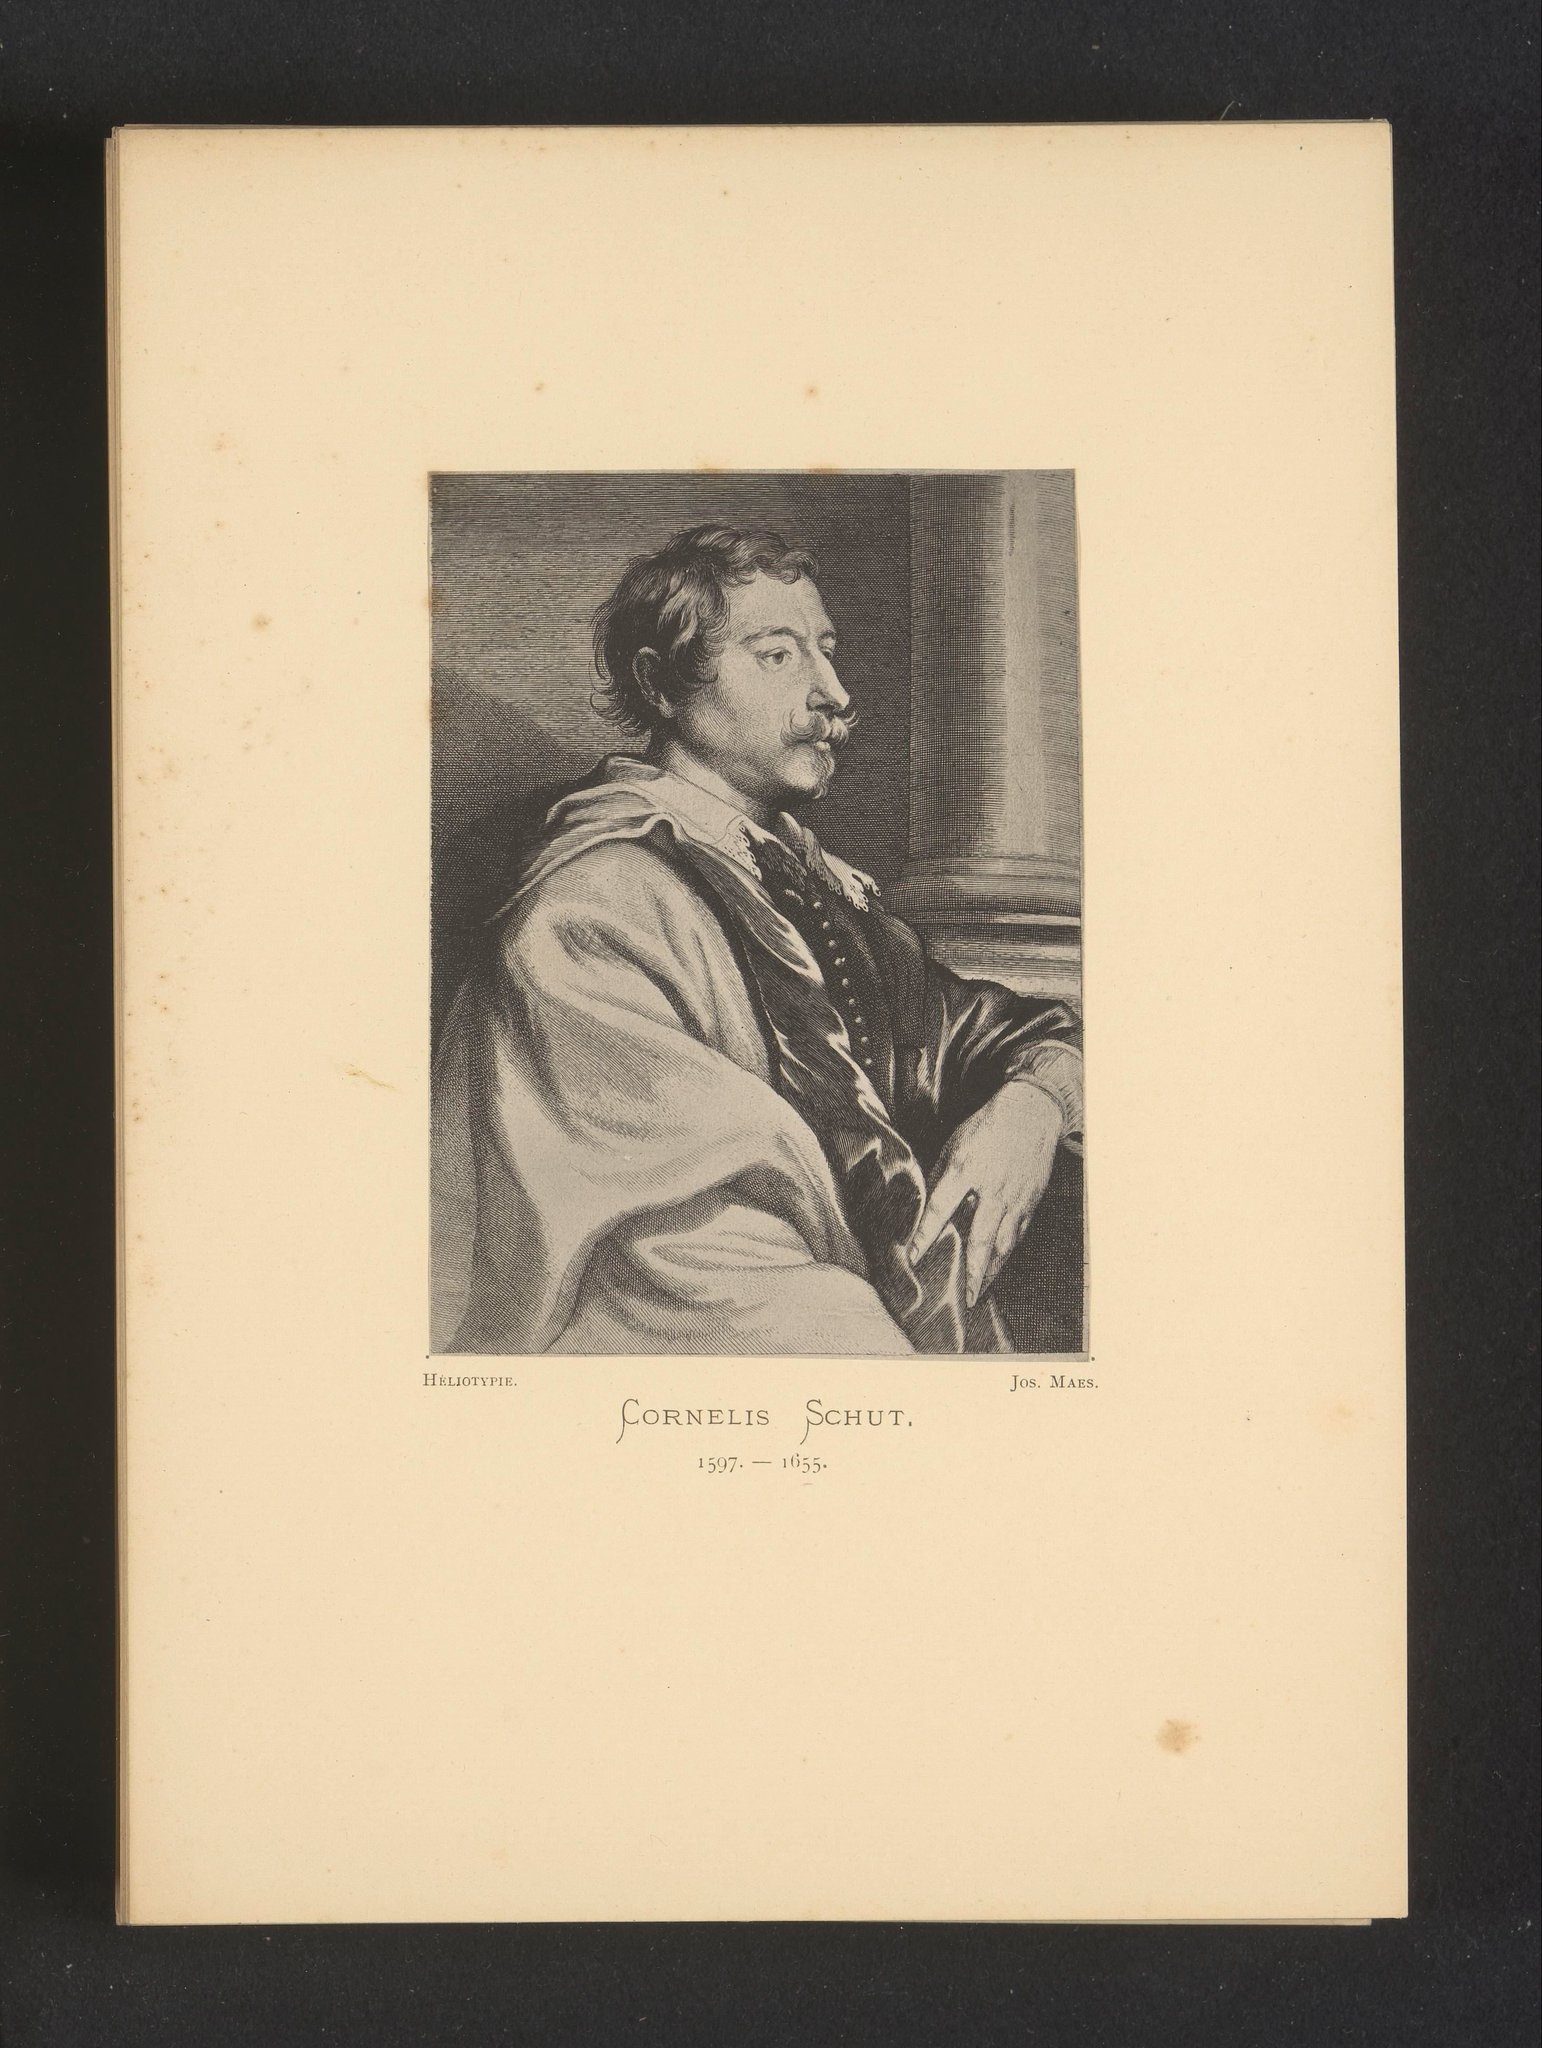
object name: reproduction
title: Cornelis Schut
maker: joseph maes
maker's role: fotograaf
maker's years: 1838-1908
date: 1872-1877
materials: cardboard, paper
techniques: photograph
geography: antwerp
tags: print maker, draughtsman, cornelis schut (i), historical persons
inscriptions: inscription: ‘1597. - 1655.’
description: Deze prent maakt deel uit van een omslag met 150 prenten en een katern met een lijst van afbeeldingen.